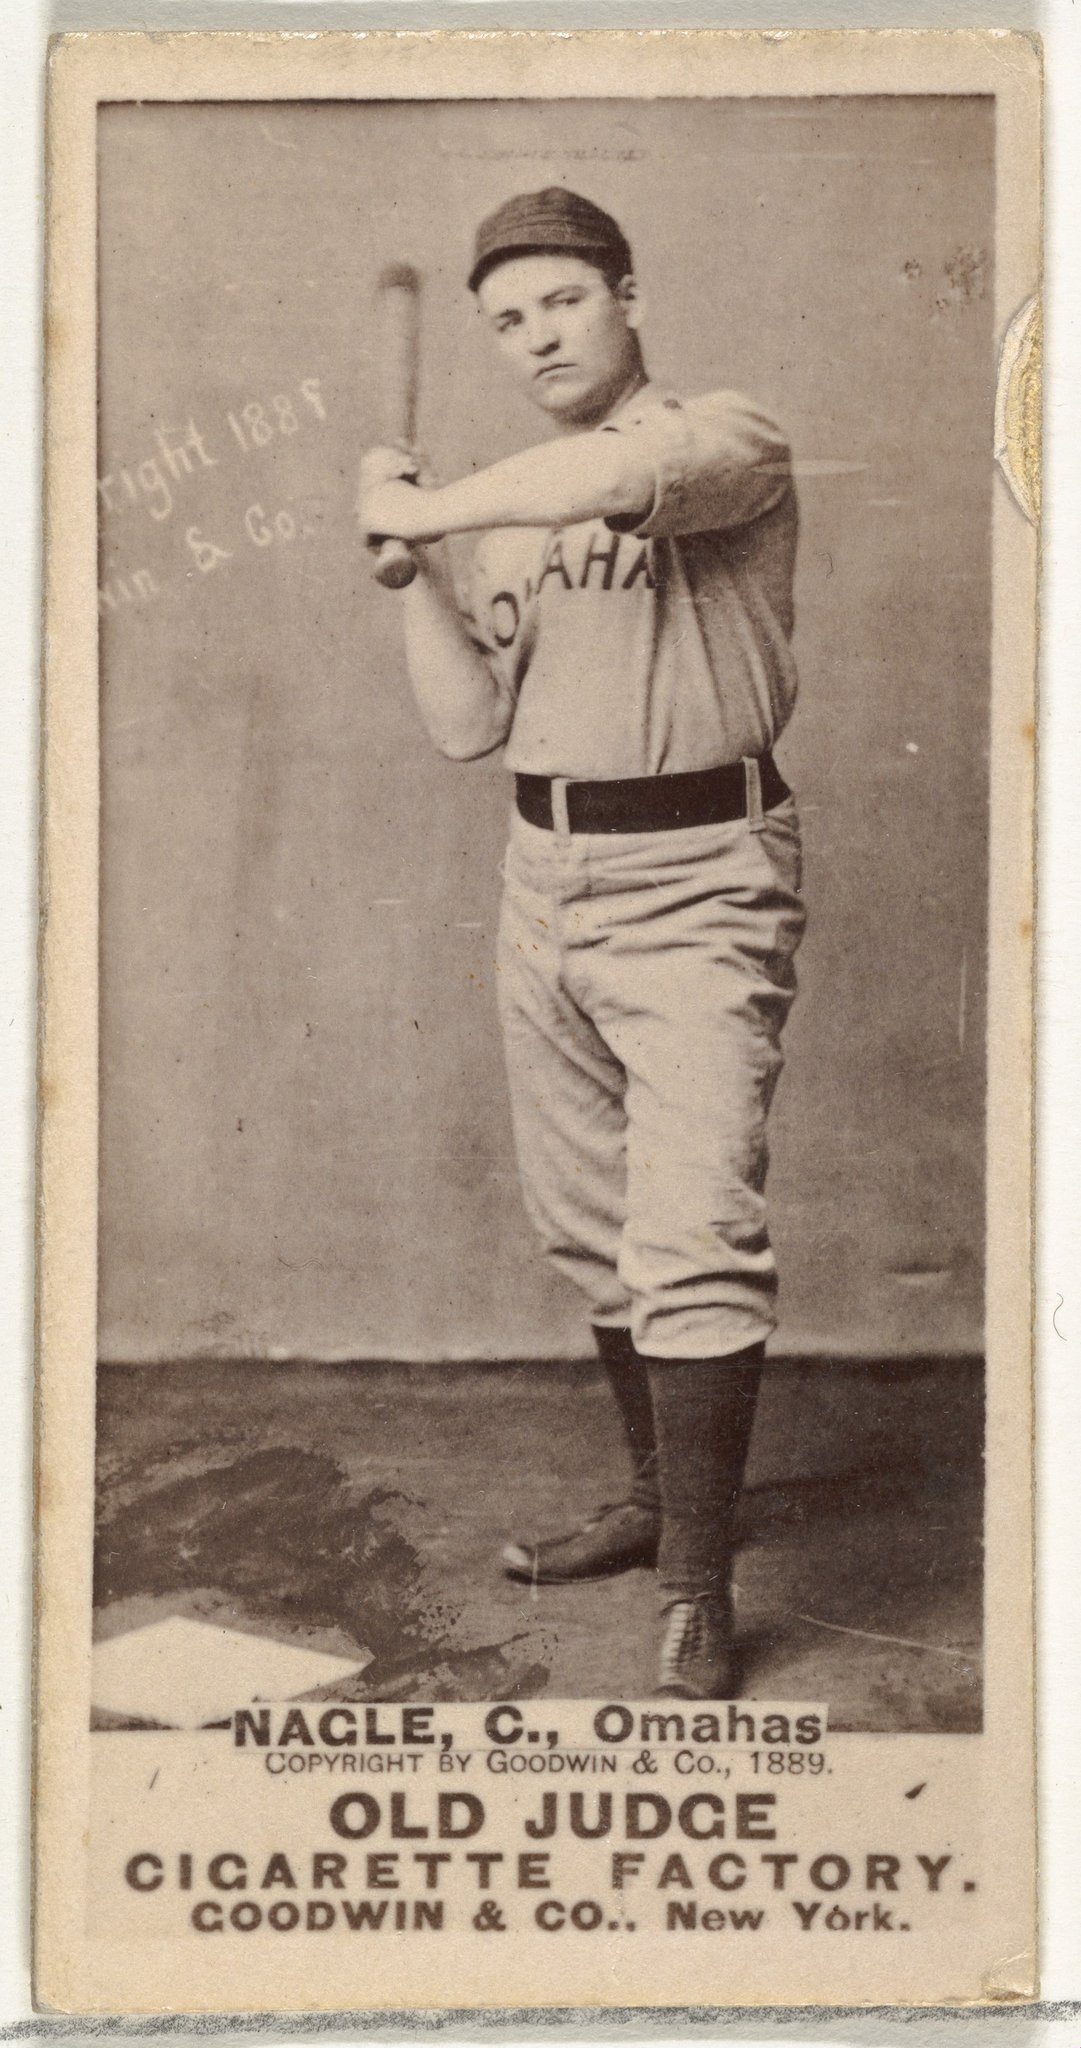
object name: baseball card, photograph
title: Nagle, Catcher, Omaha Omahogs/ Lambs, from the Old Judge series (N172) for Old Judge Cigarettes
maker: goodwin & company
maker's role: publisher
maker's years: 1850-1950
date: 1889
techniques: albumen silver print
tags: men,portraits,baseball,athletes